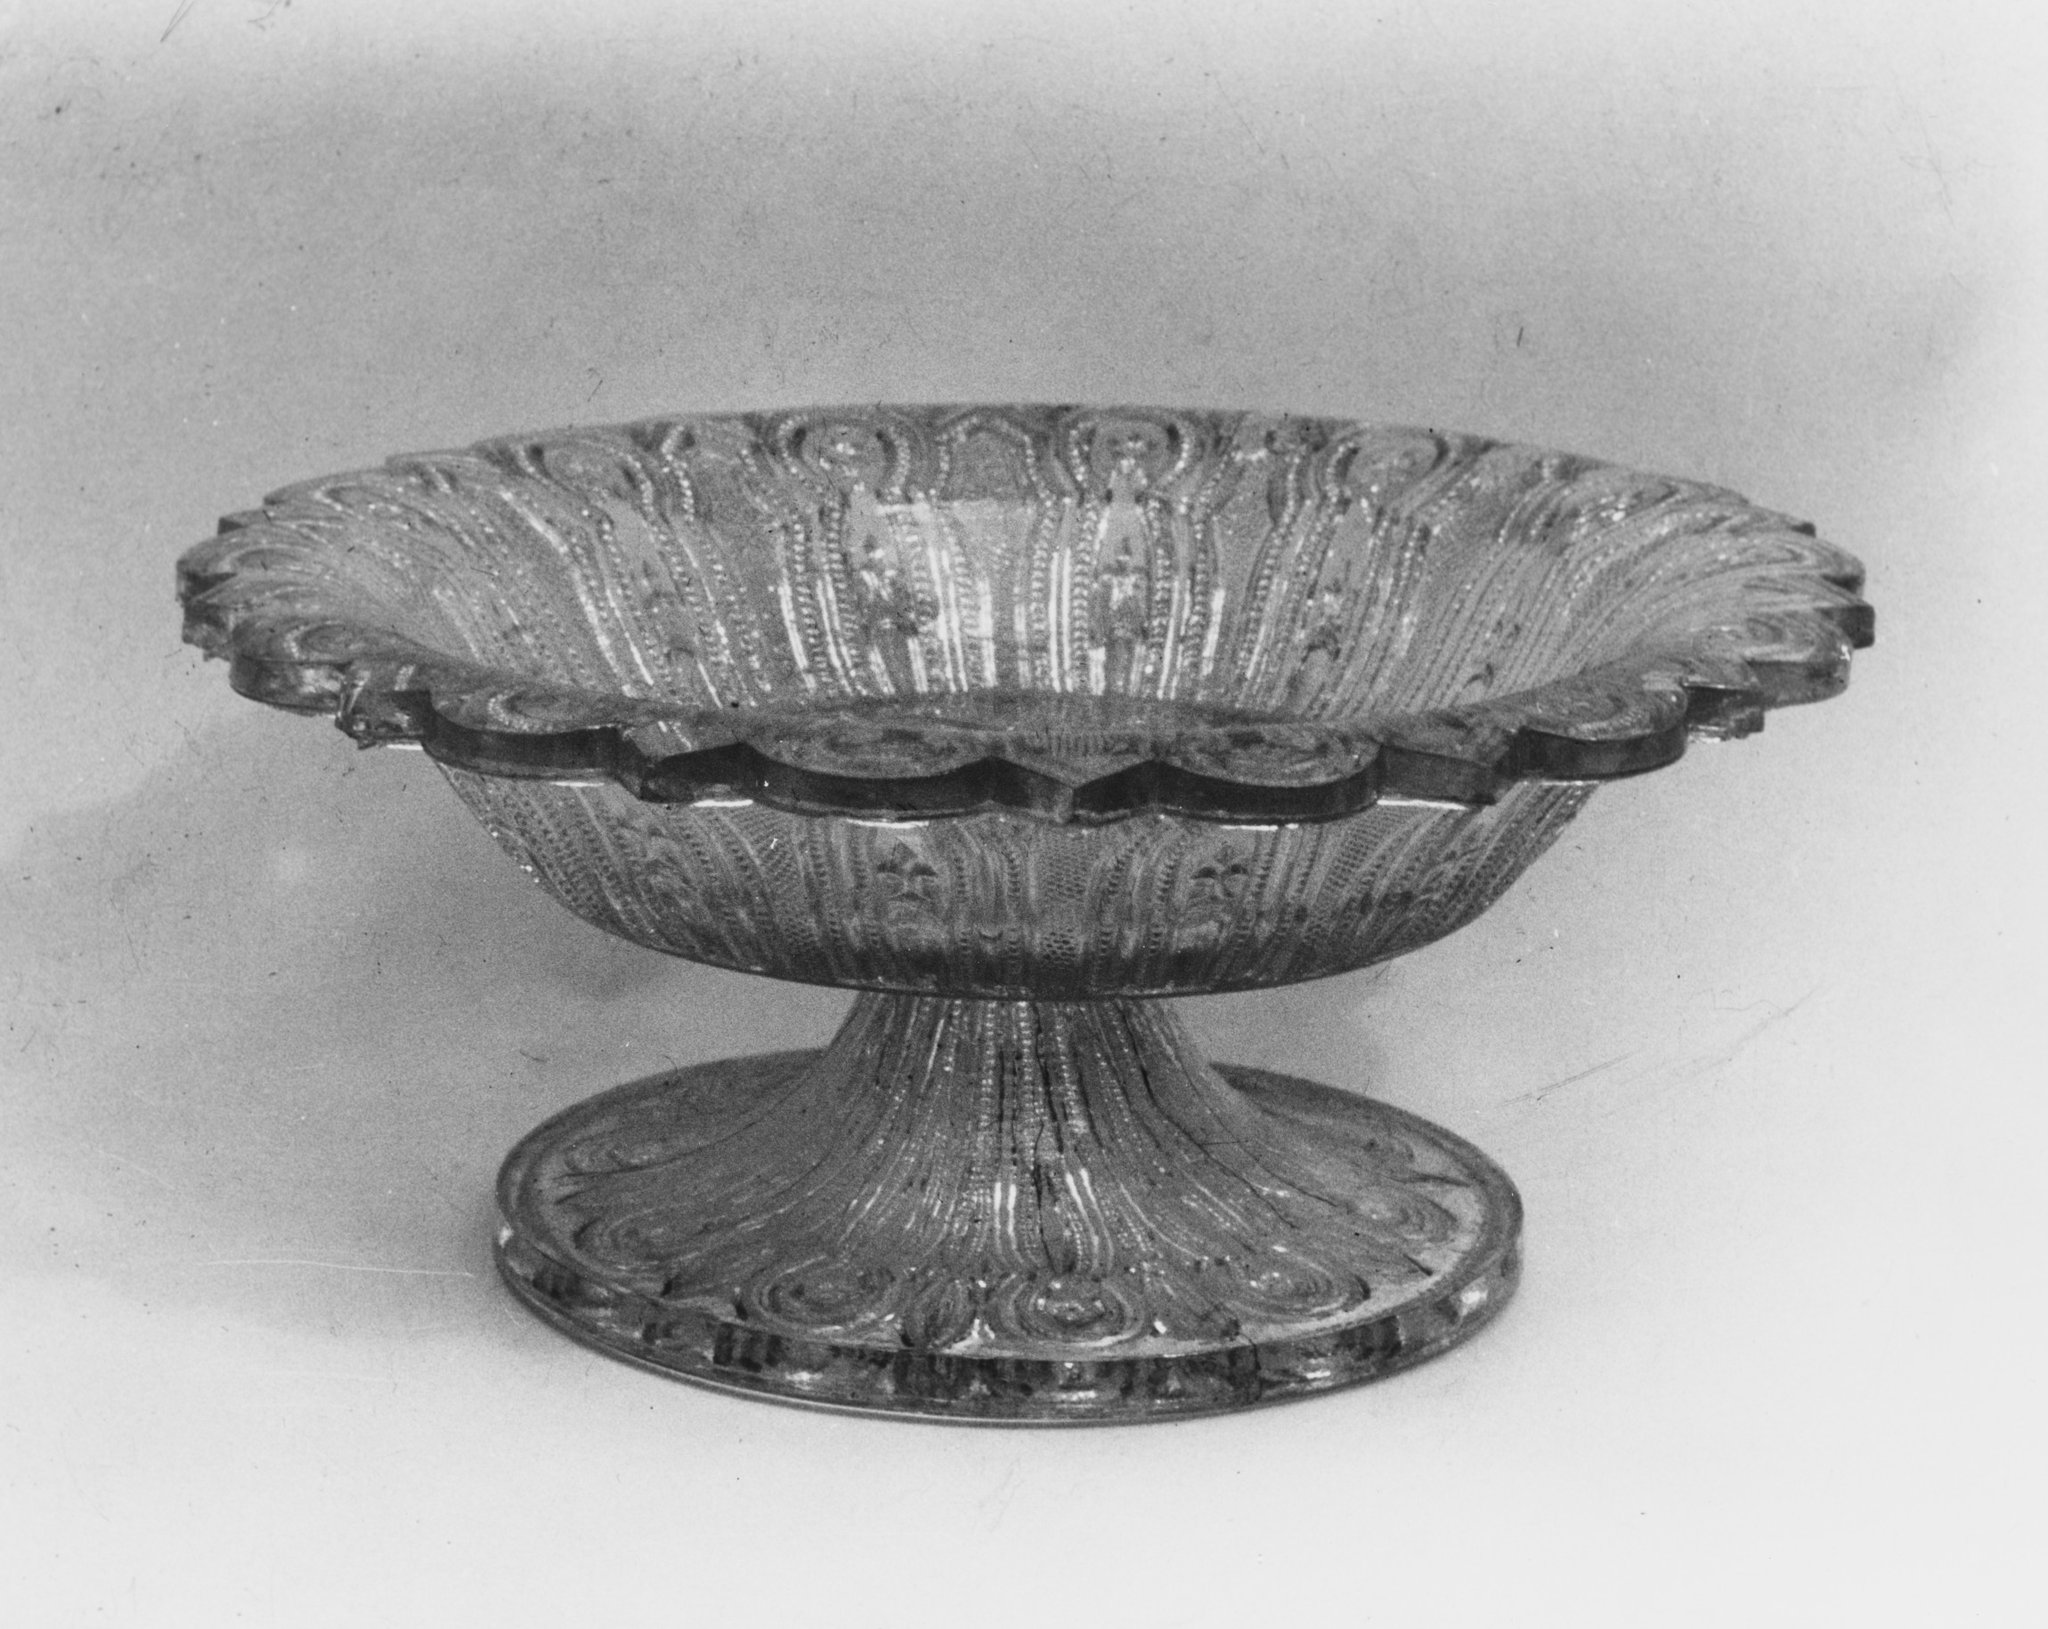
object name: compote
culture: american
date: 1830-1835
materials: glass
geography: united states